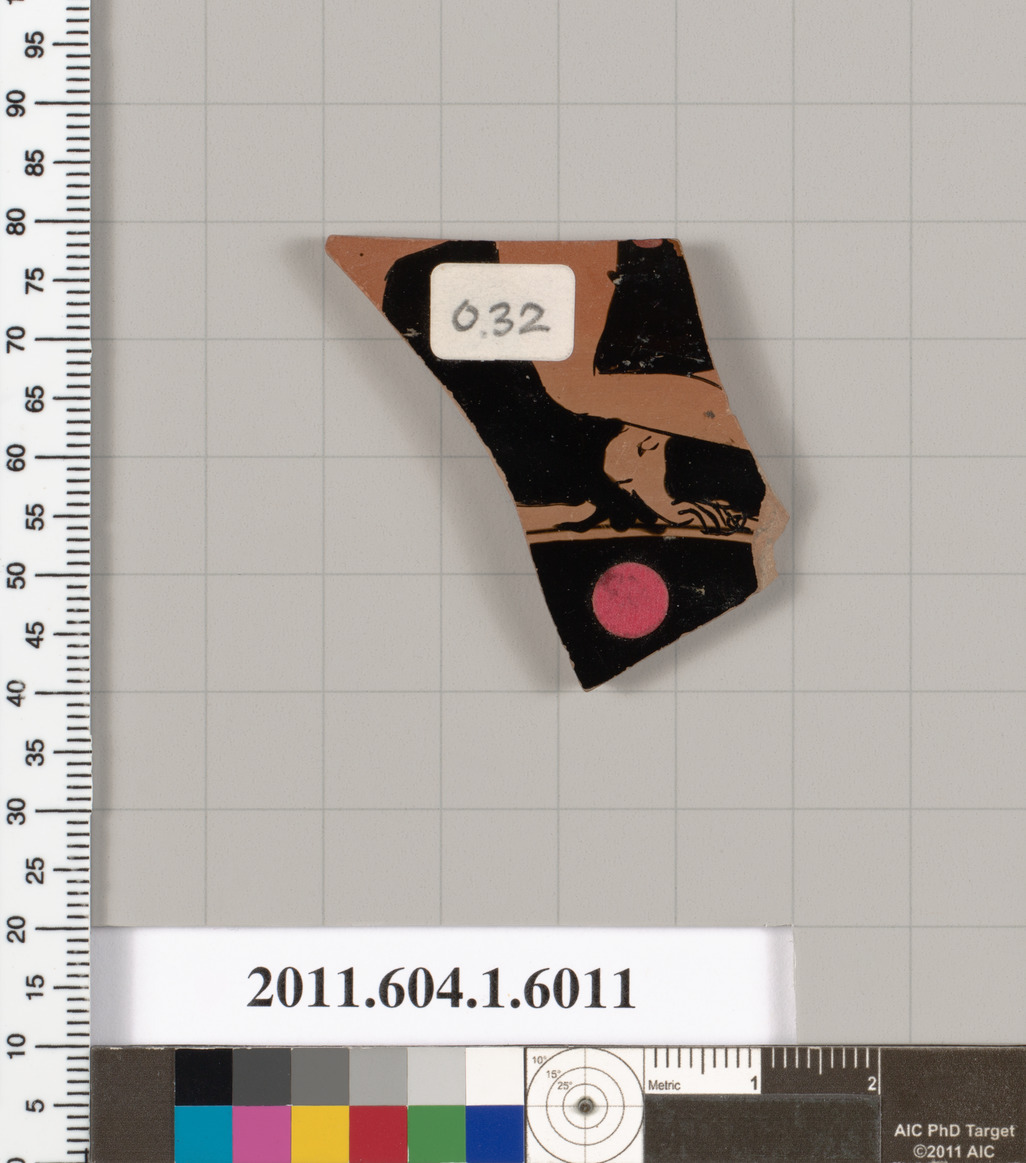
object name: kylix fragment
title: Terracotta fragment of a kylix (drinking cup)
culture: greek, attic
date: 510-500 BCE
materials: terracotta